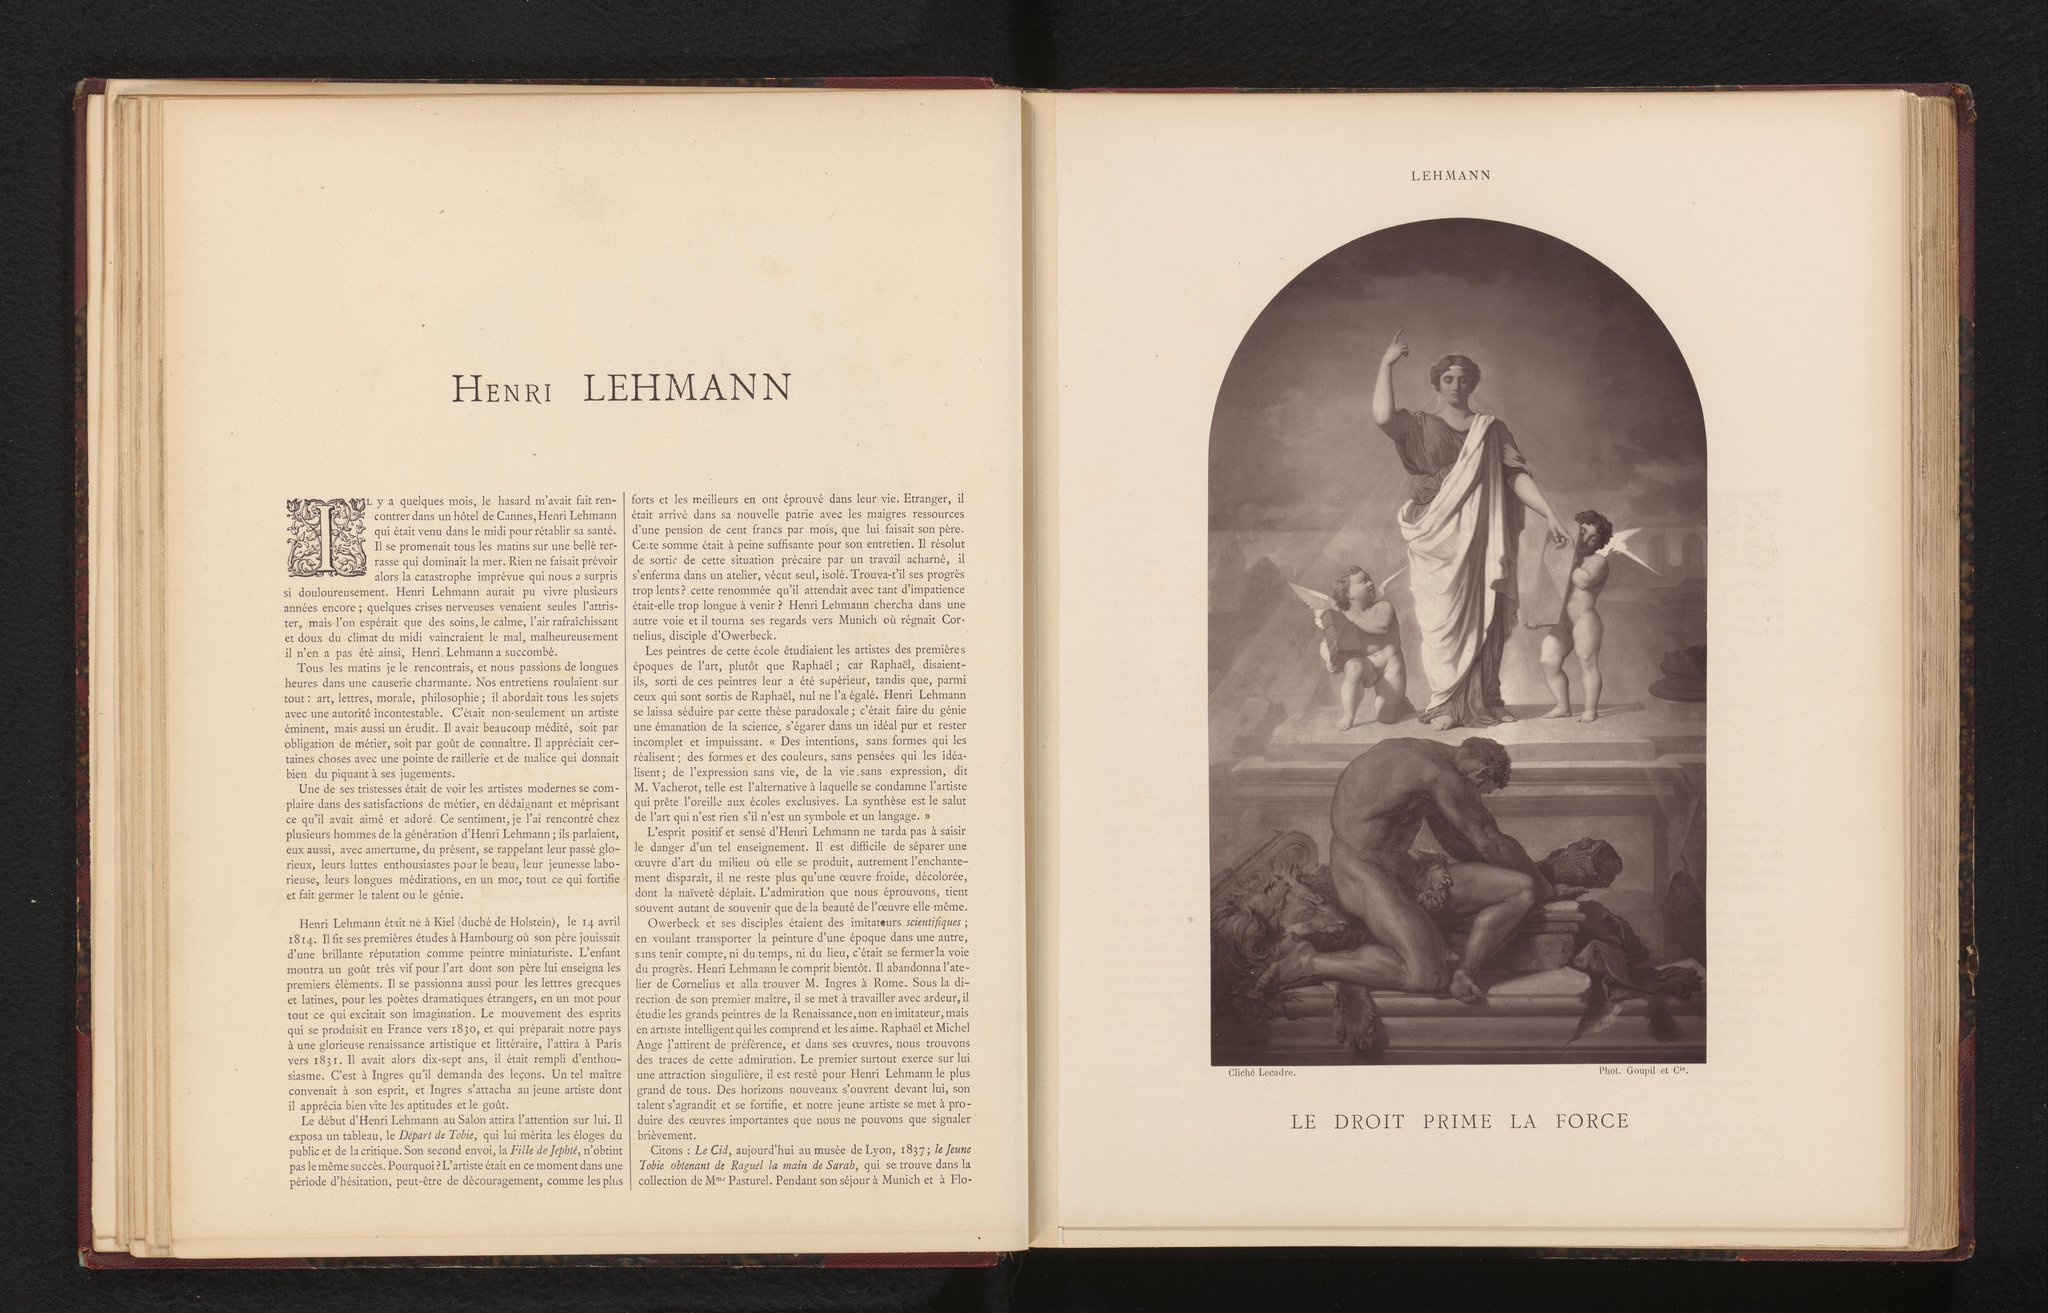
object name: reproduction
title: Le droit prime la force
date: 1878-1883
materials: paper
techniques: woodburytype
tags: justice, 'justitia'; 'giustitia divina' (ripa) ~ one of the four cardinal virtues